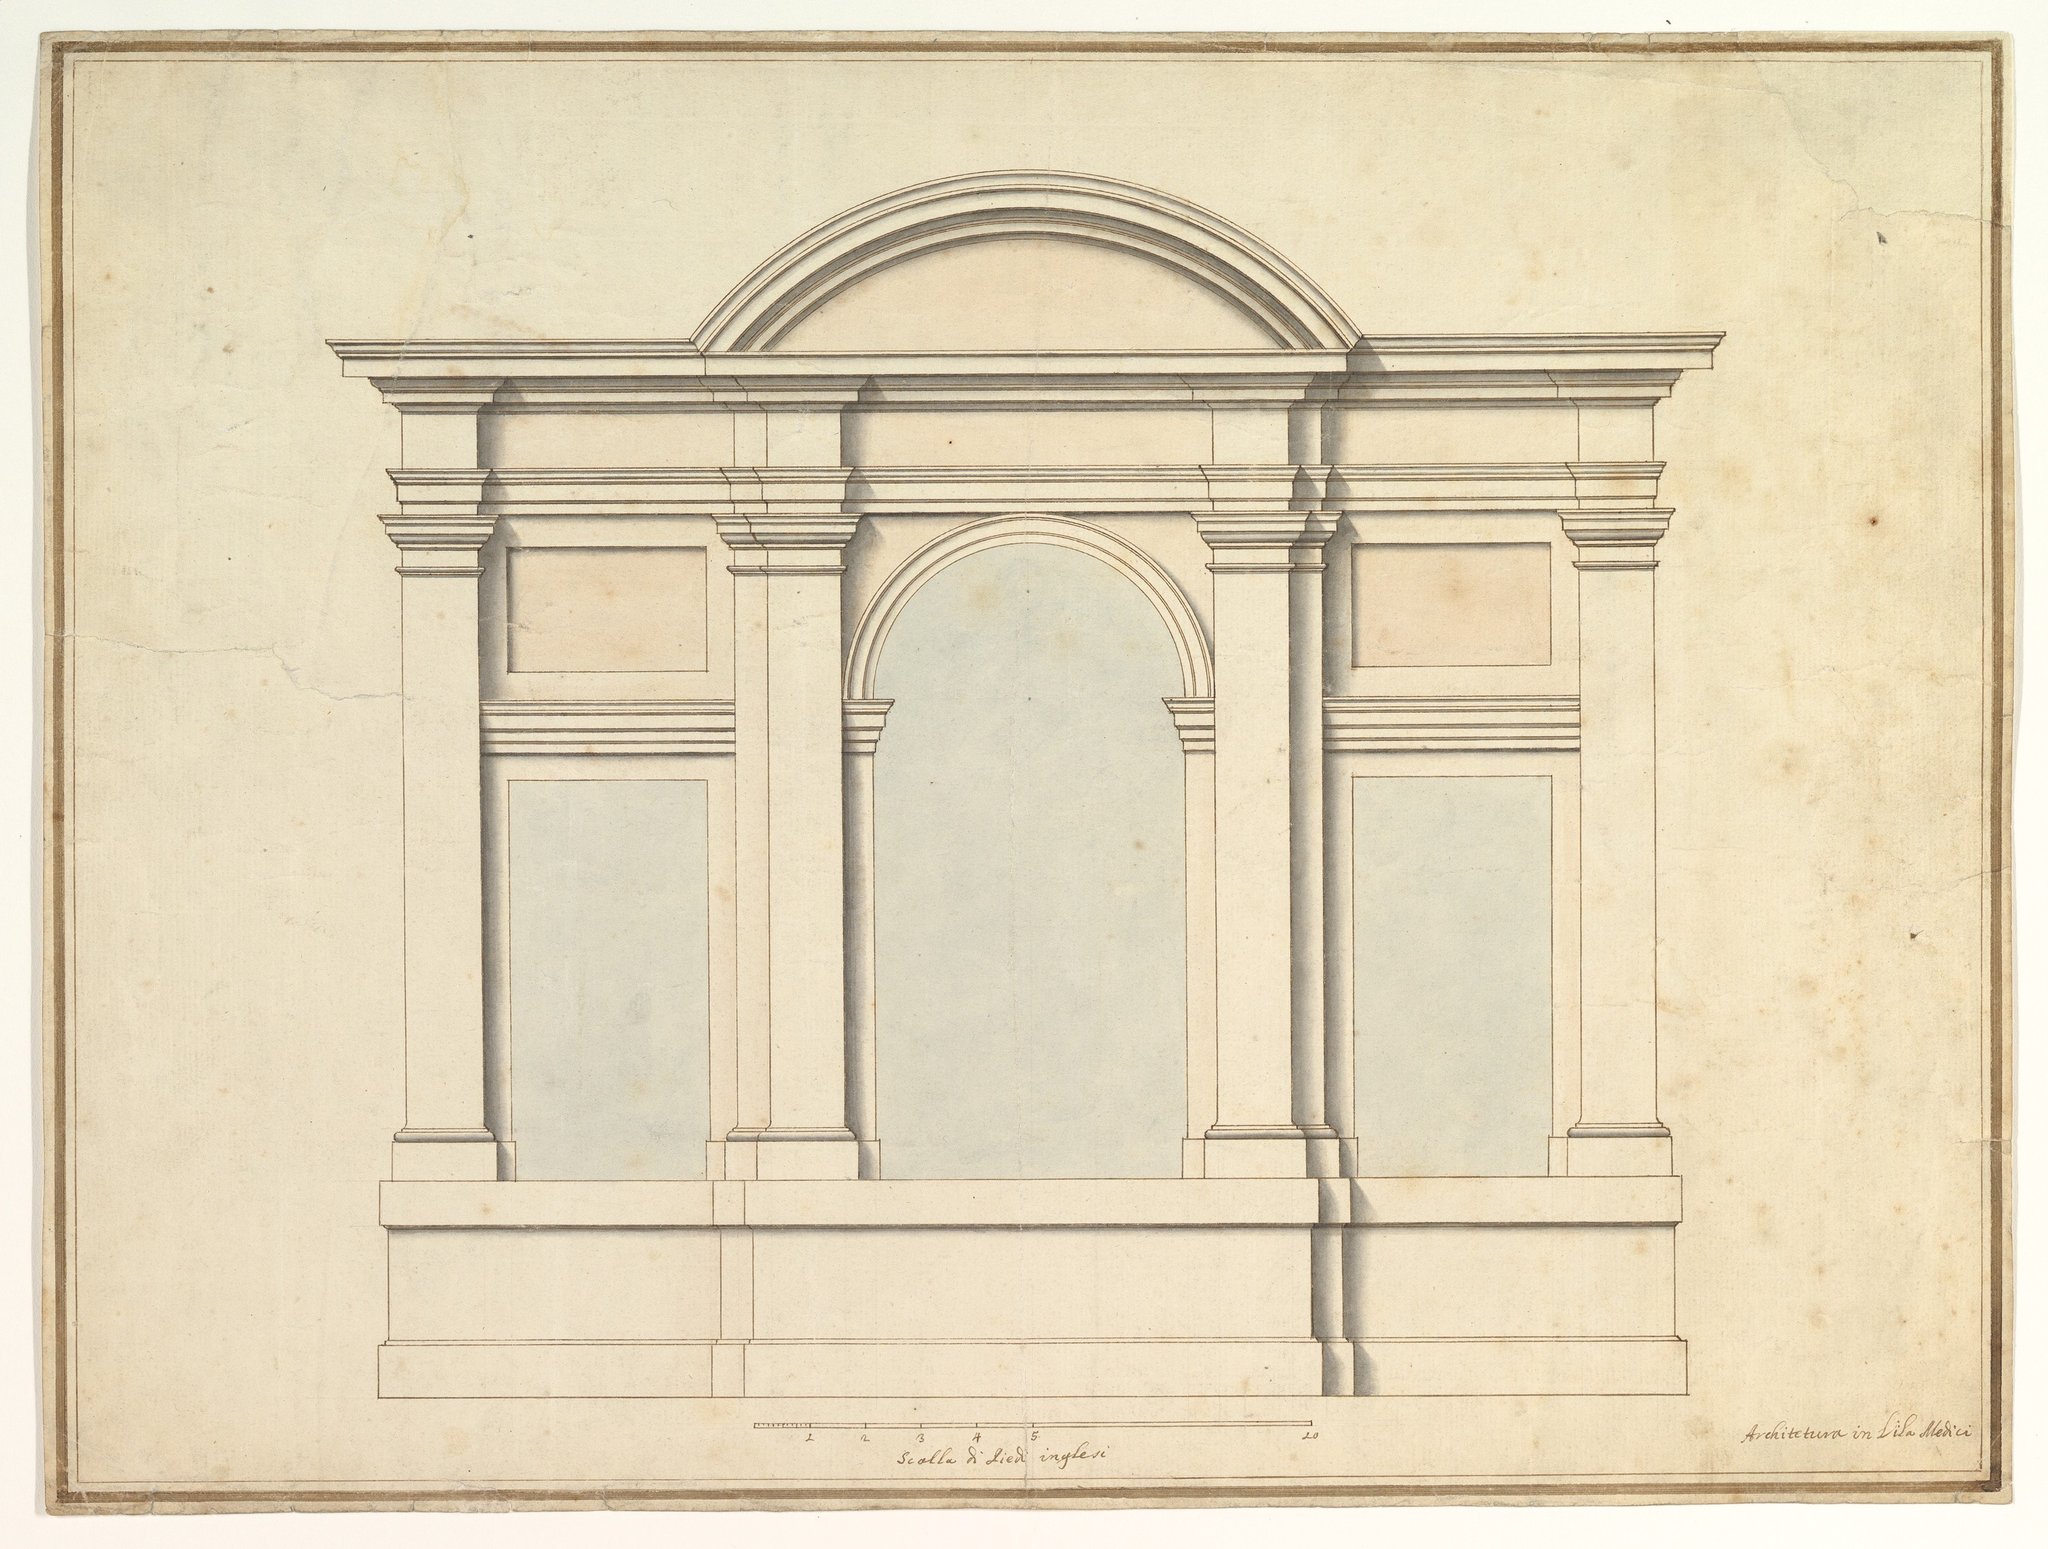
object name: drawing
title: Elevation of Wall Decoration in the Villa Medici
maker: antonio visentini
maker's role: artist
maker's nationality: italian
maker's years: 1688-1782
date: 1688-1782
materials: ink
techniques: brush, pen, wash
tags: architecture